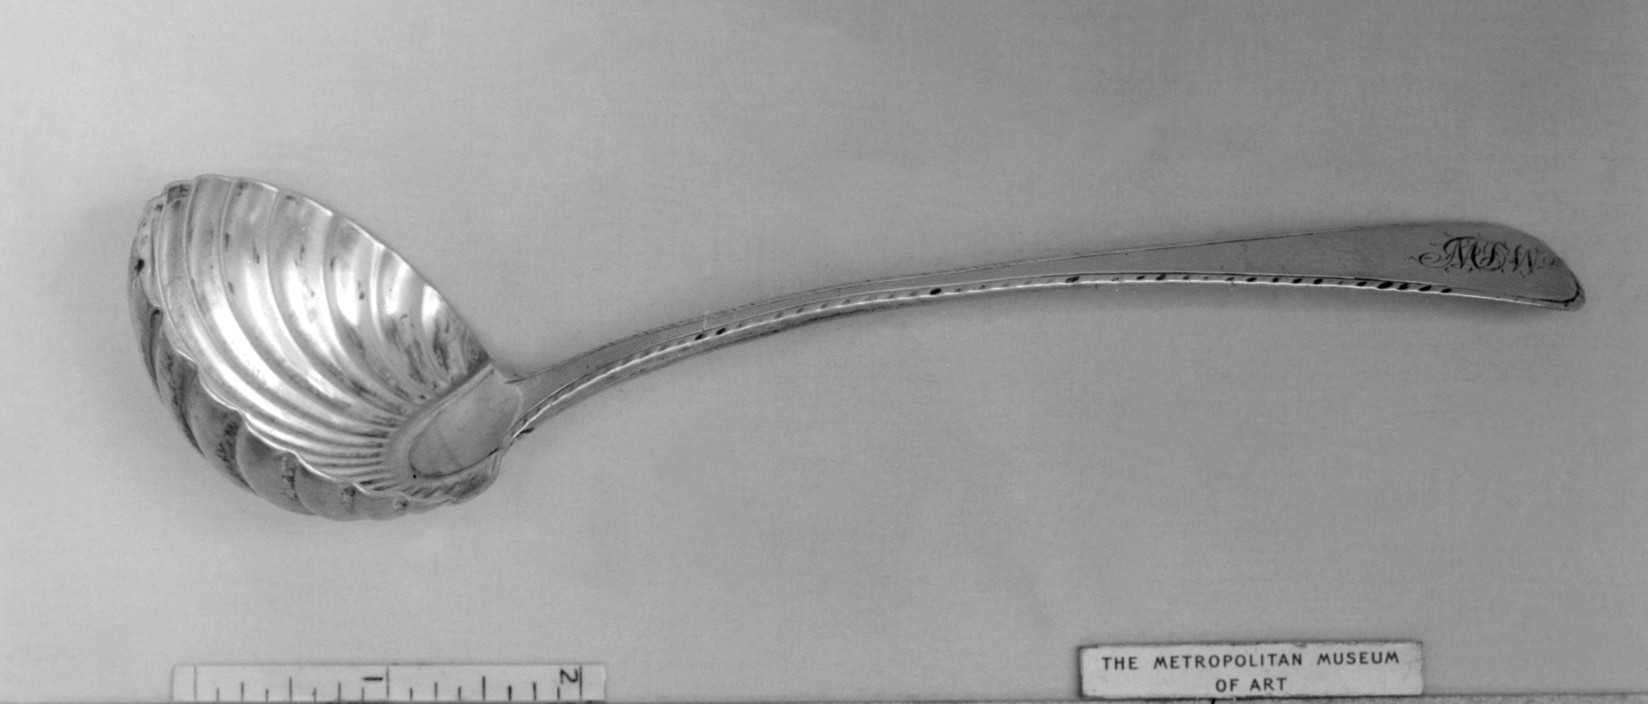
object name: ladle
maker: thomas chawner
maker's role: maker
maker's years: 1759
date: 1760-1780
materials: silver